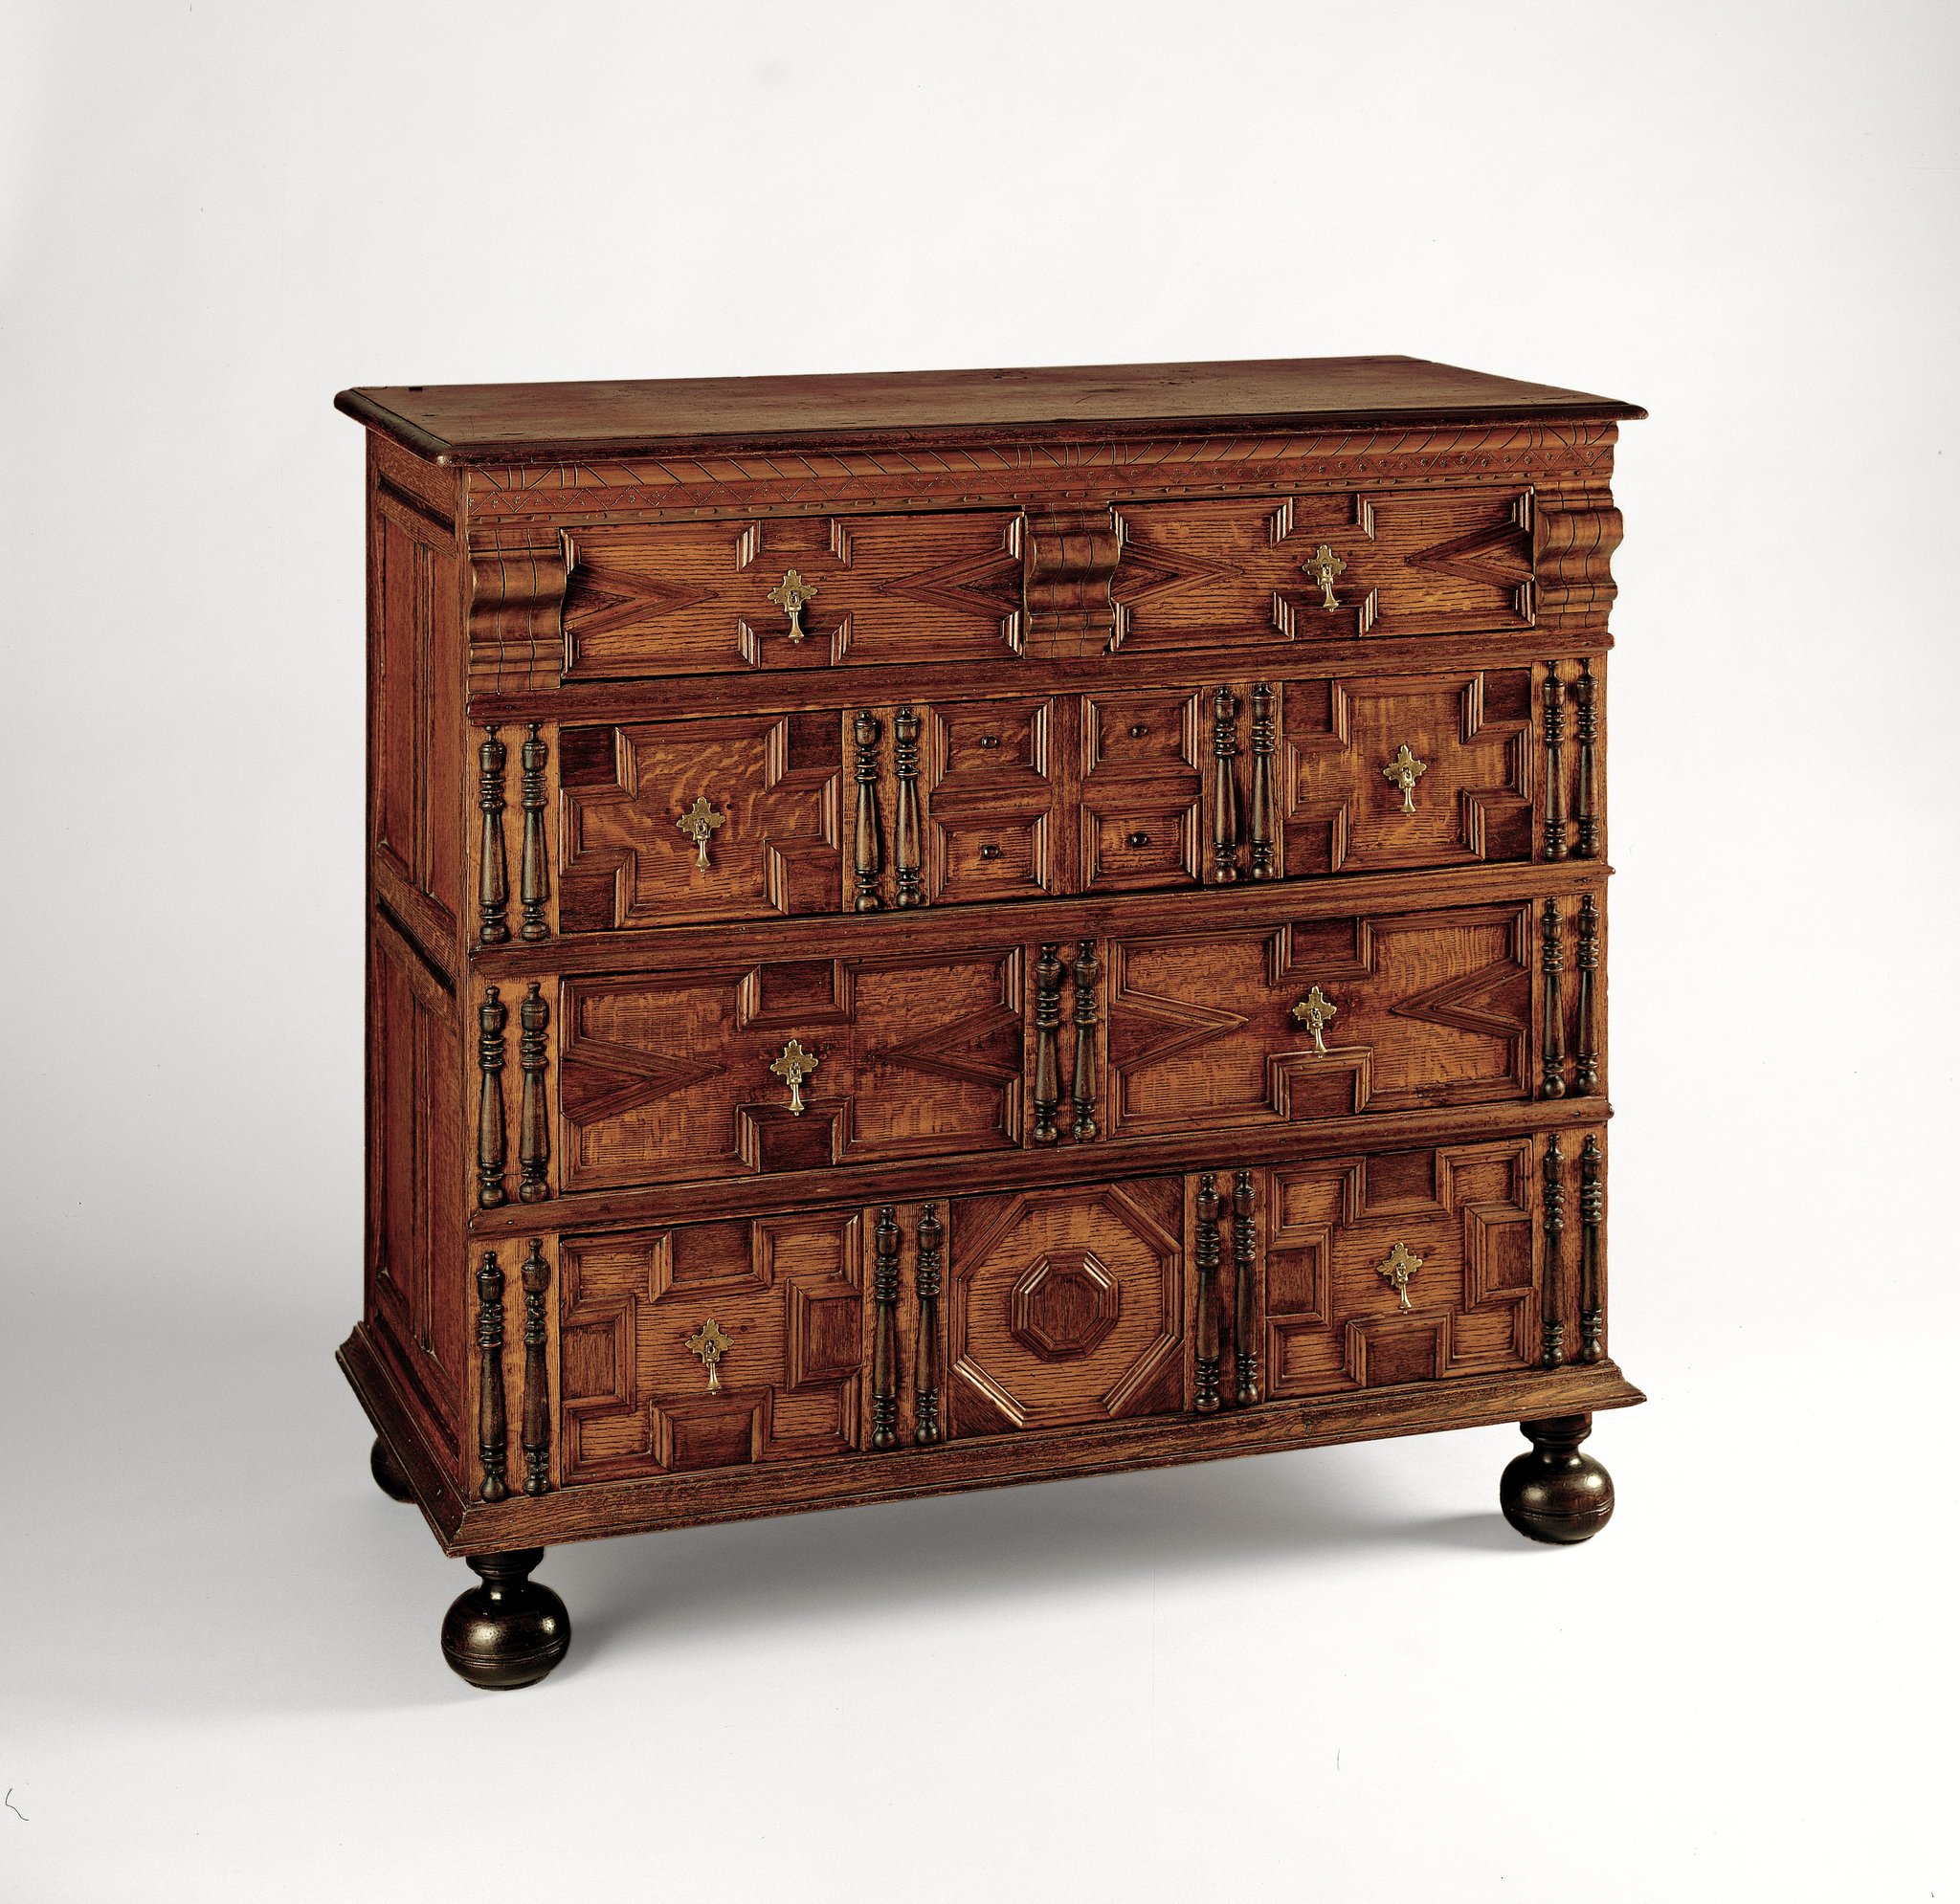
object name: chest of drawer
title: Chest of drawers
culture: american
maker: the symonds shop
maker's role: maker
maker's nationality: american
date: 1675-1700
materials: wood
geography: united states